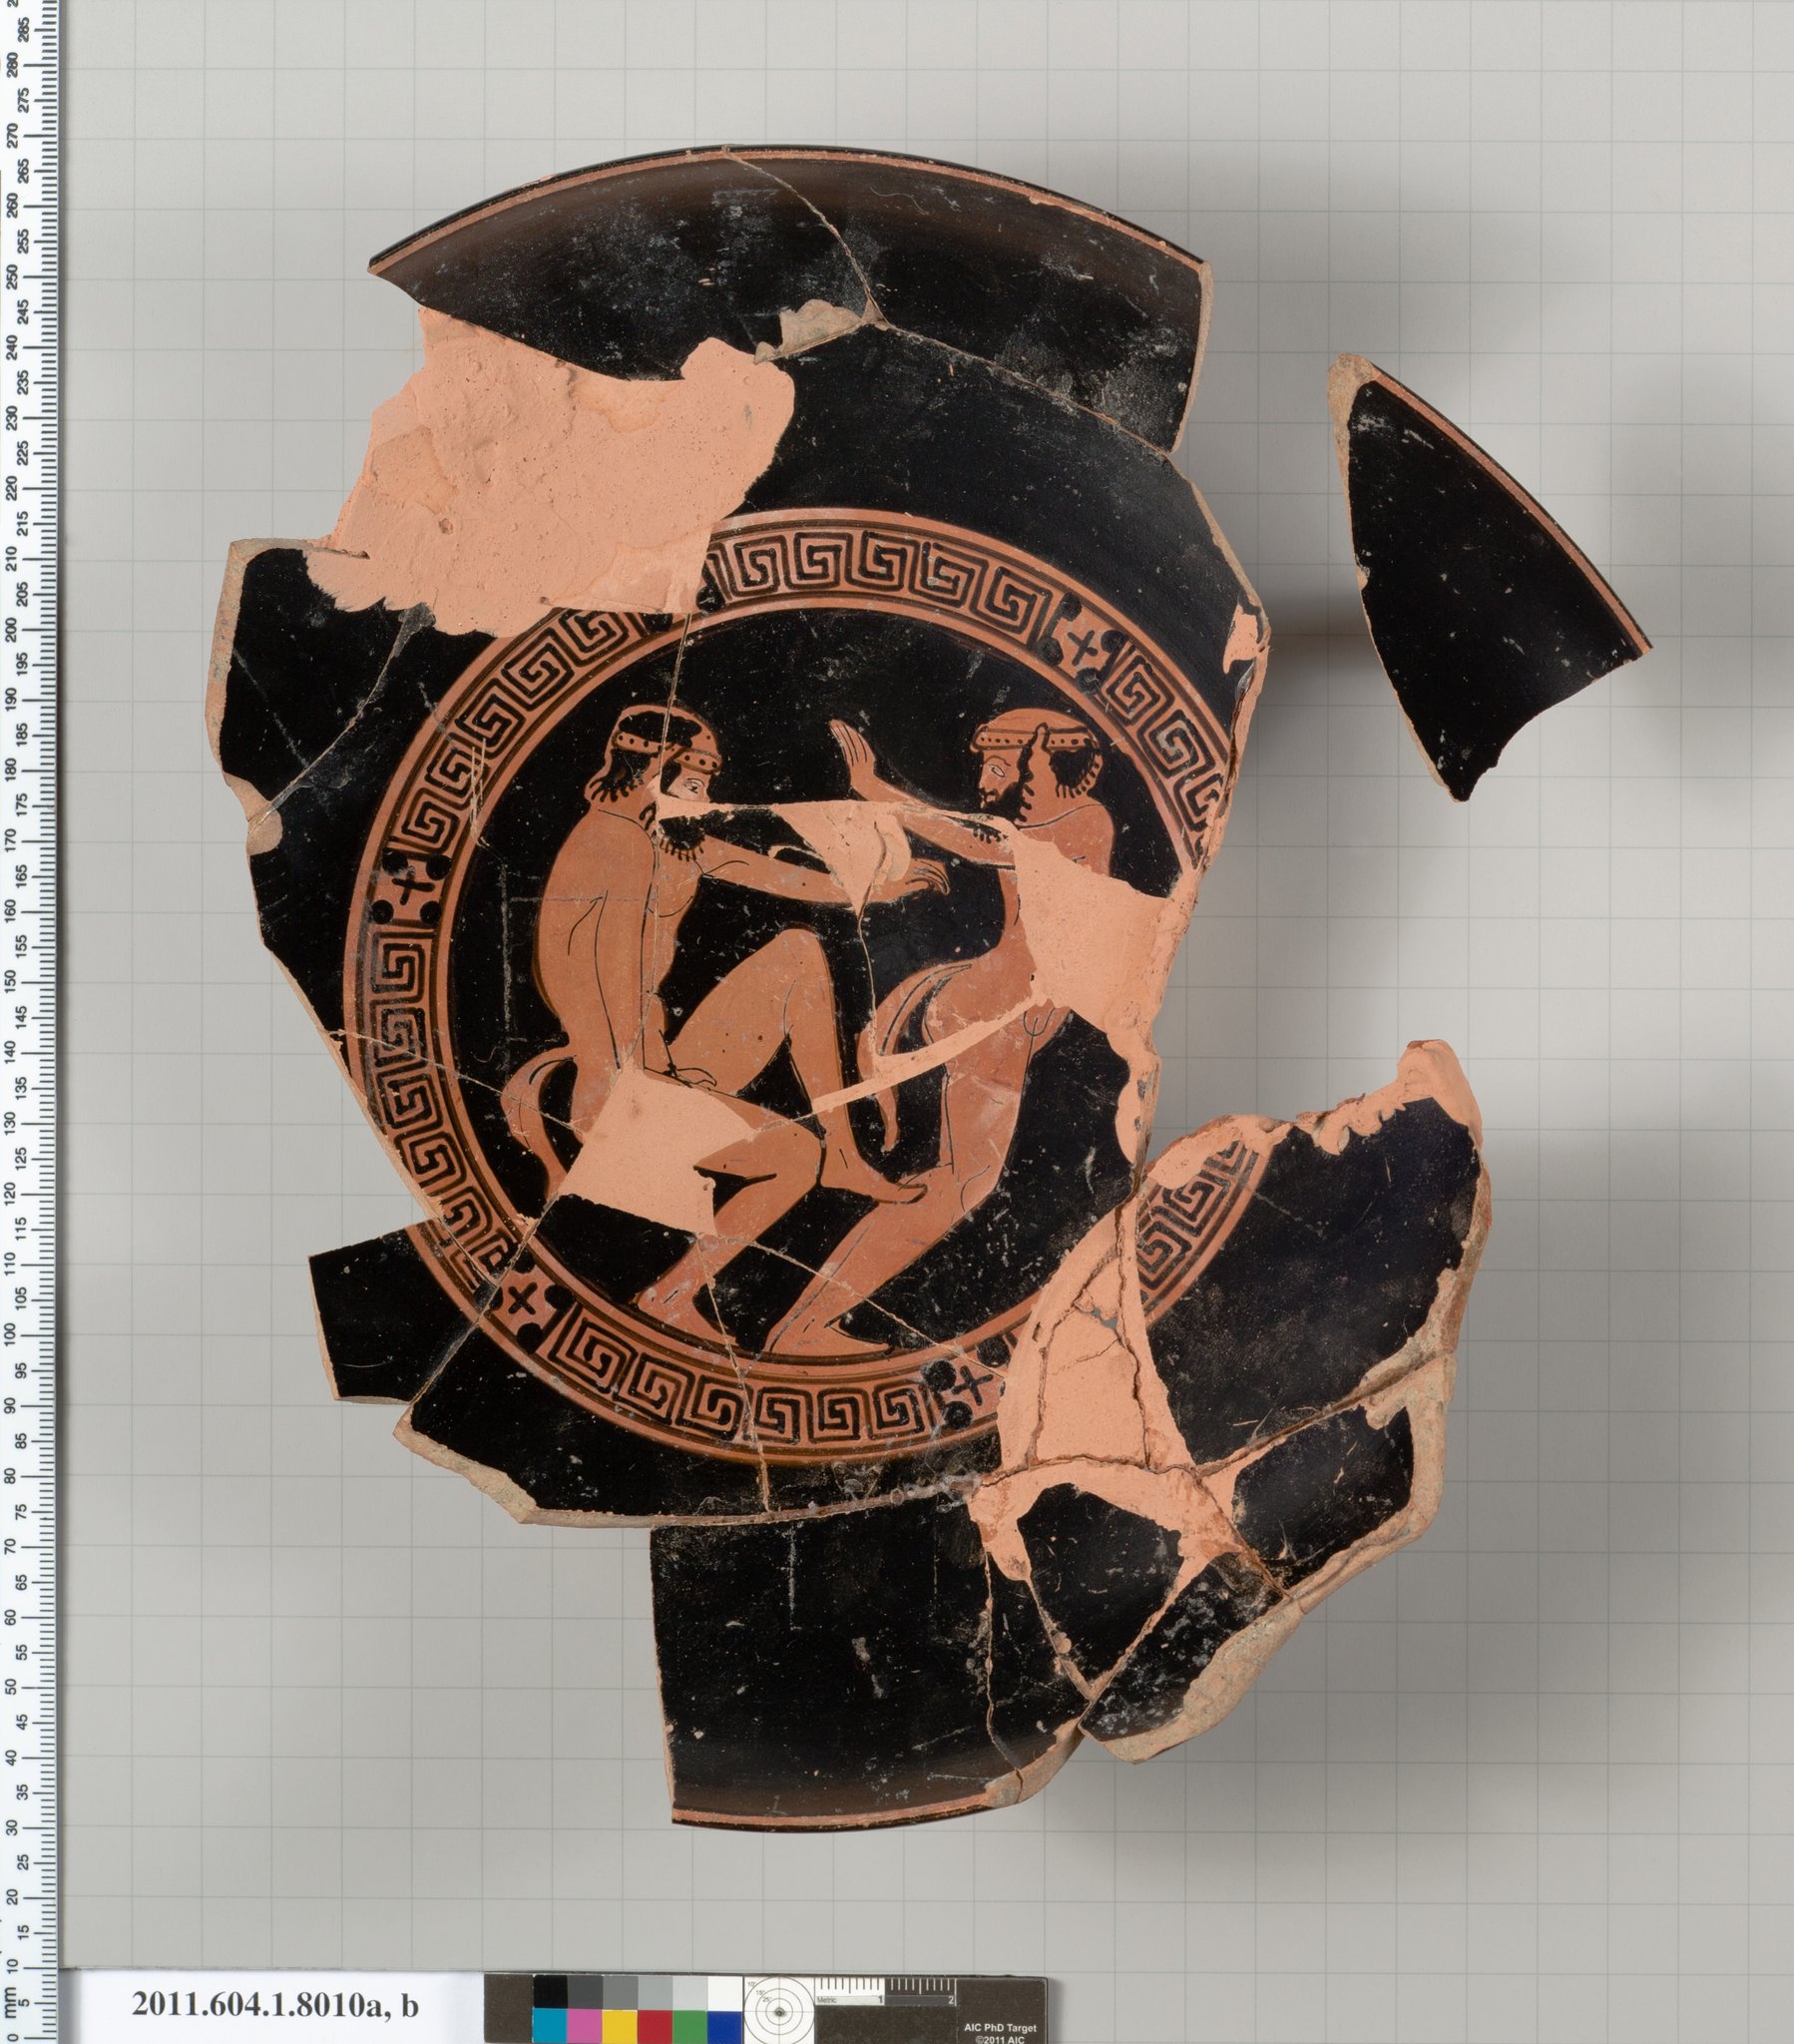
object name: kylix fragment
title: Terracotta fragments of a kylix (drinking cup)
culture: greek, attic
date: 460-450 BCE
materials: terracotta